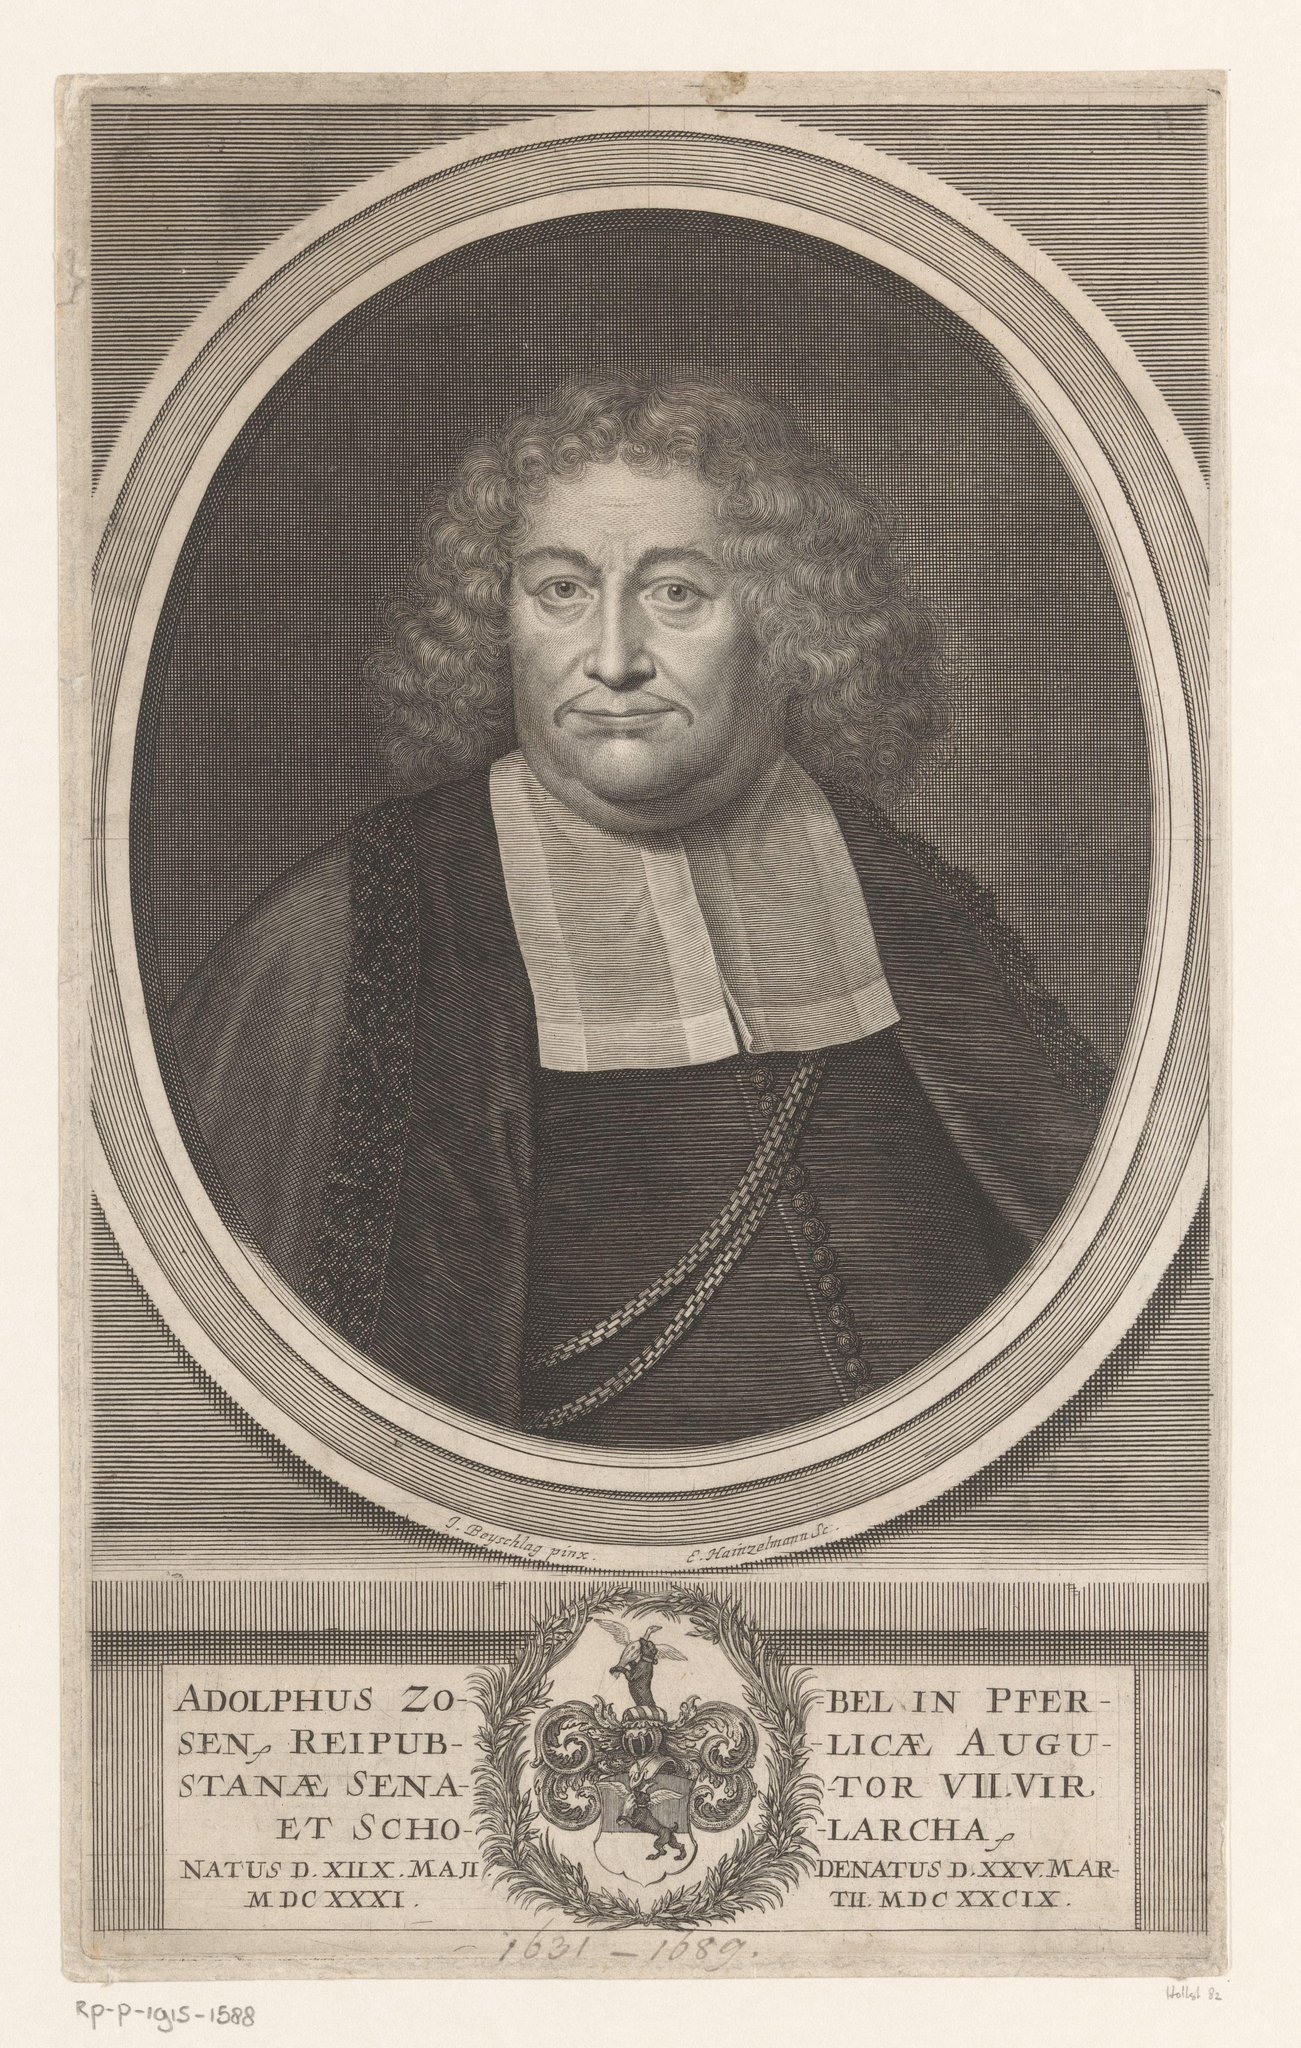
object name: print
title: Portret van Adolph Zobel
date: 1689-1693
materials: paper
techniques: engraving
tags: augsburg, historical persons, armorial bearing, heraldry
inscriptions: collector's mark: Lugt 2228